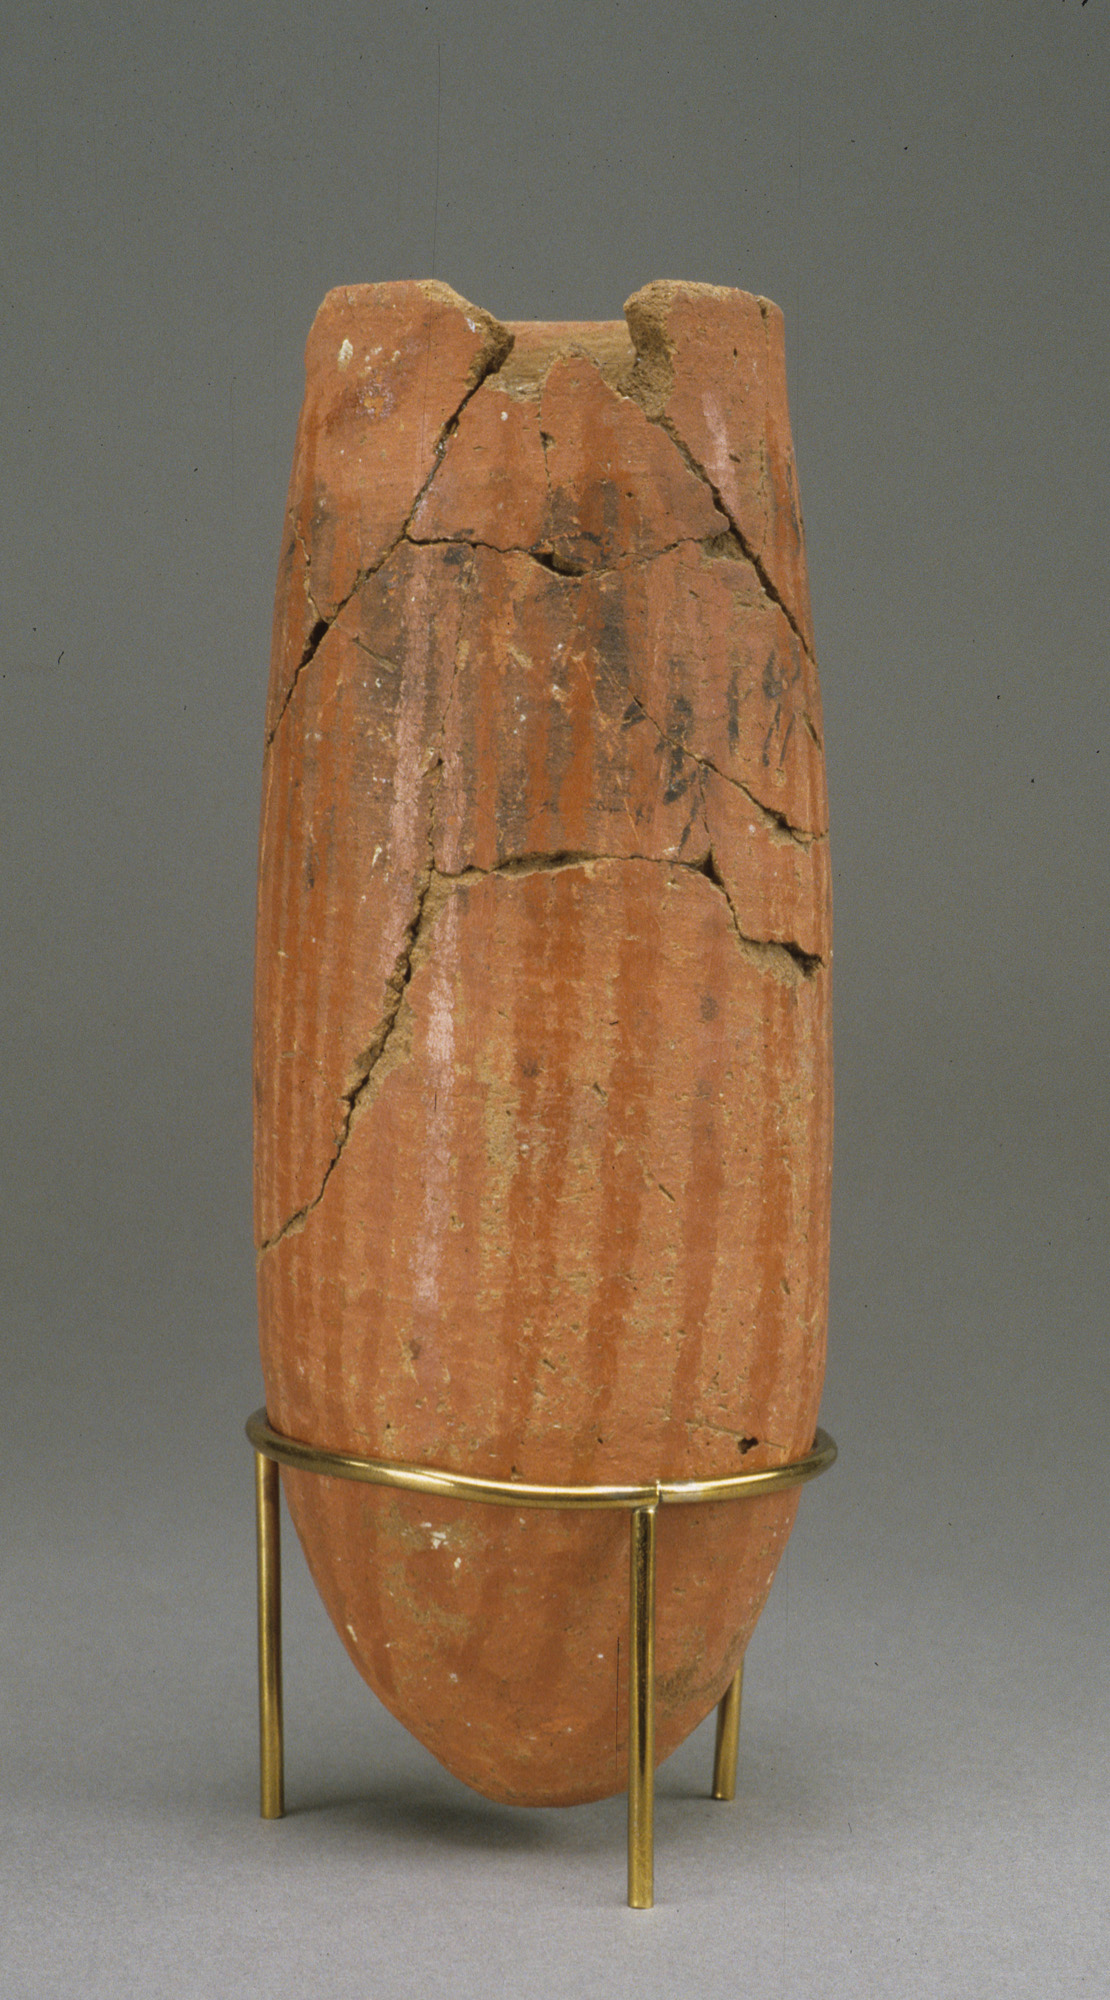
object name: situla, red polished ware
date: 1550-1458 BCE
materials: paint, pottery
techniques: polish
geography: egypt